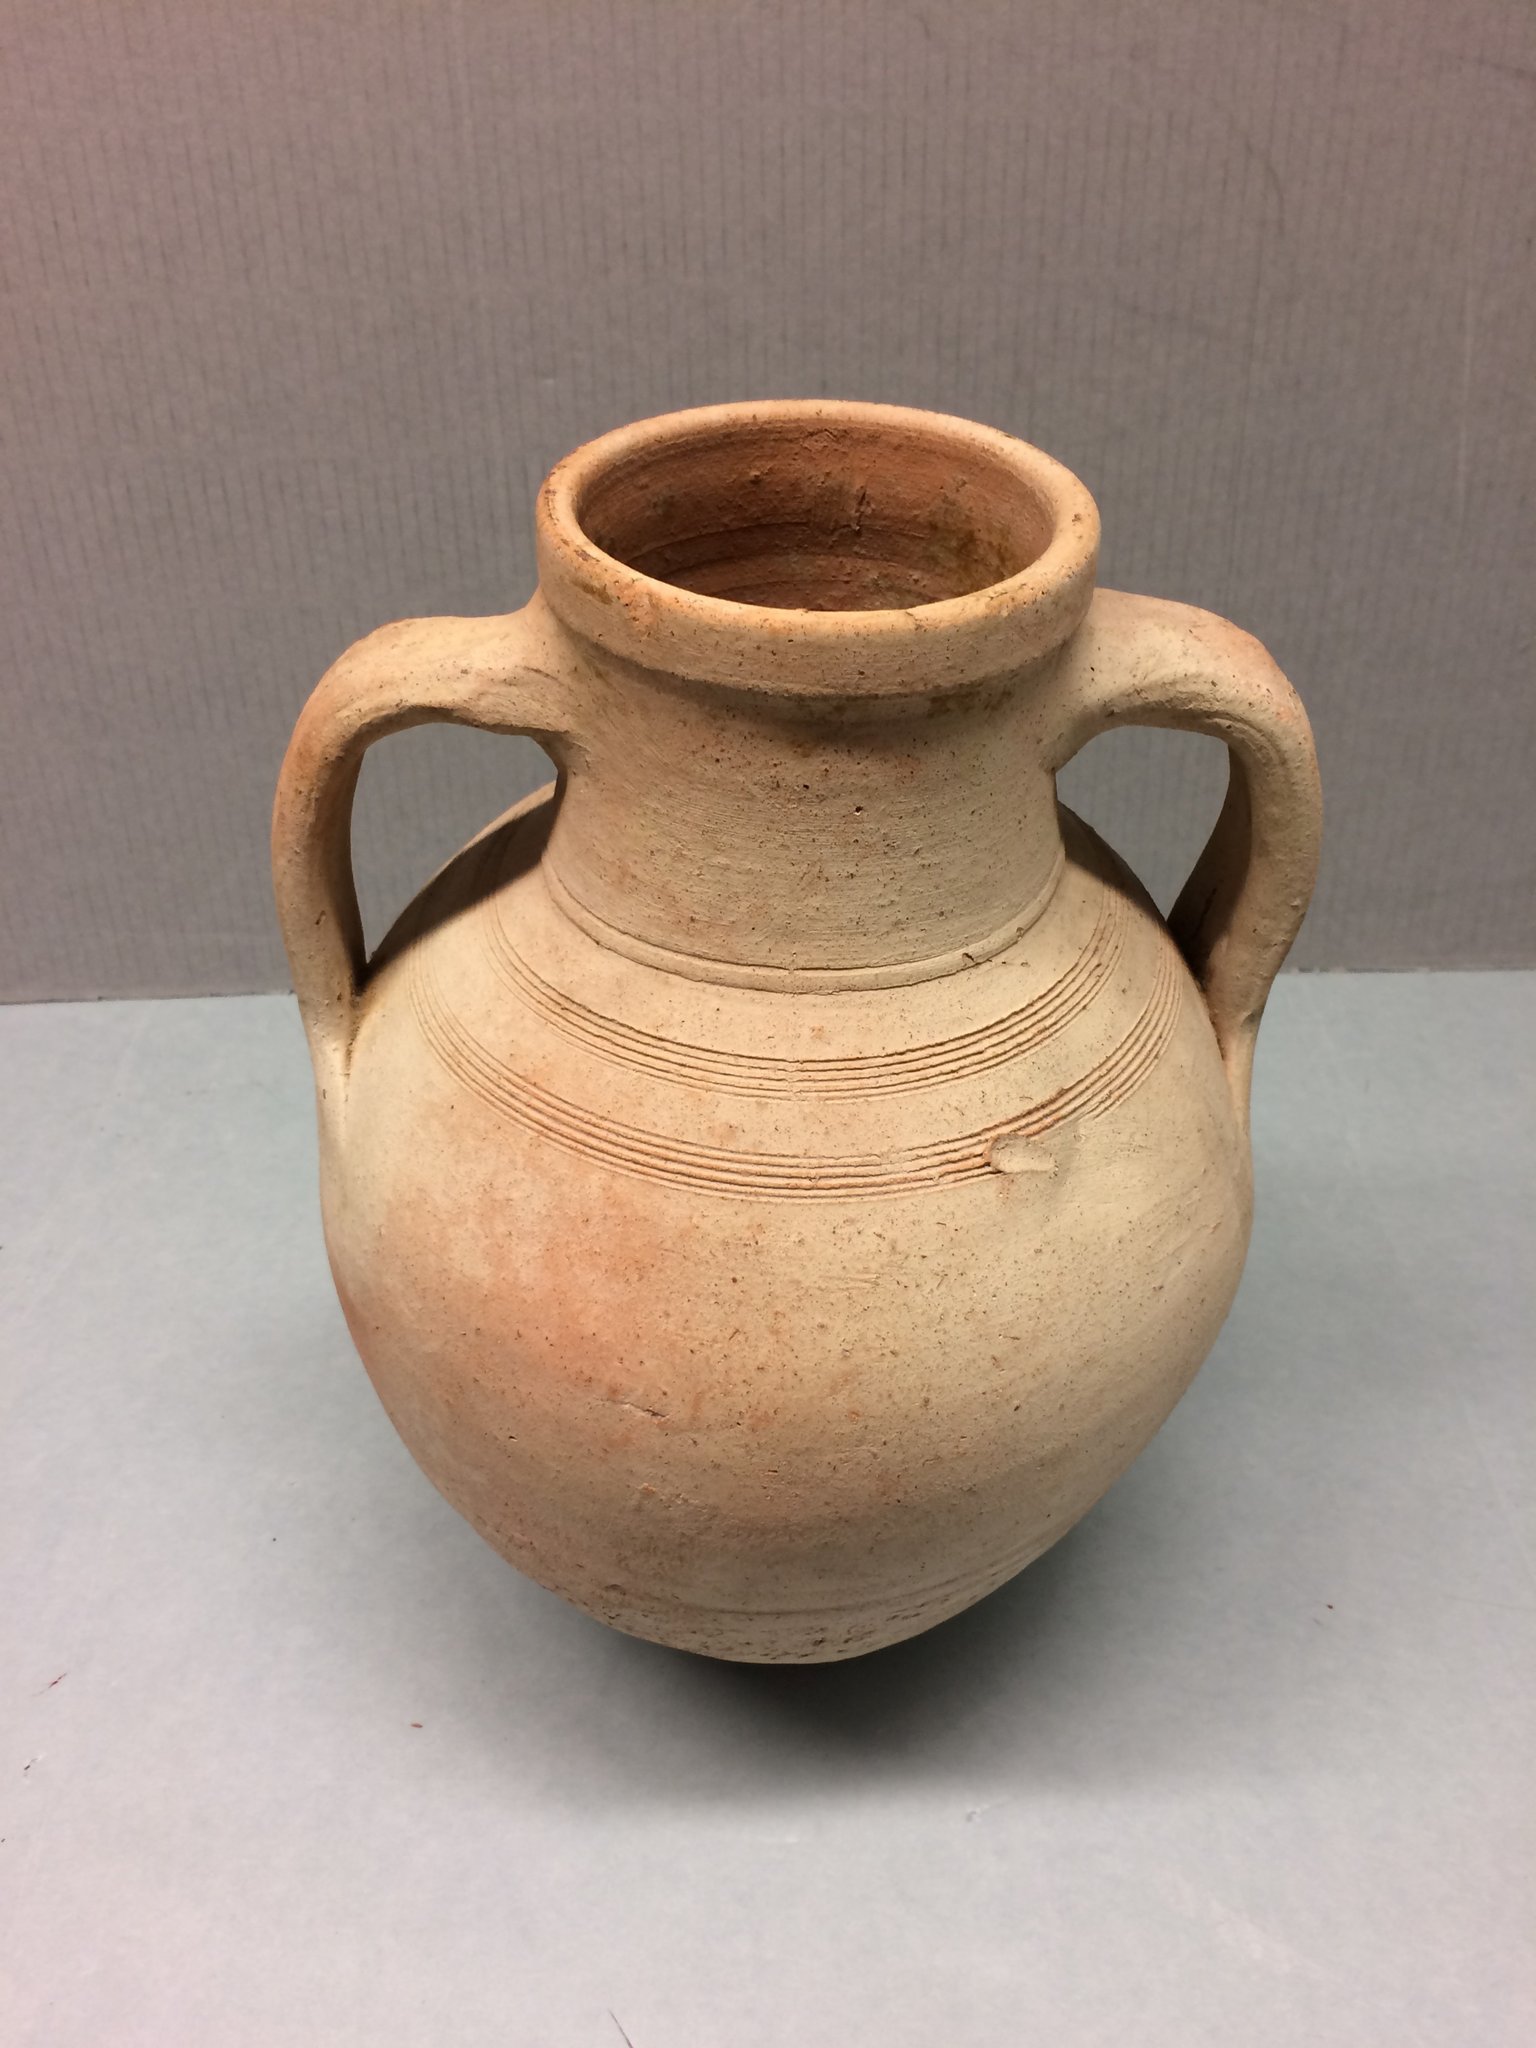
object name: jar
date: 1001-1200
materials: earthenware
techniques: incising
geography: iran